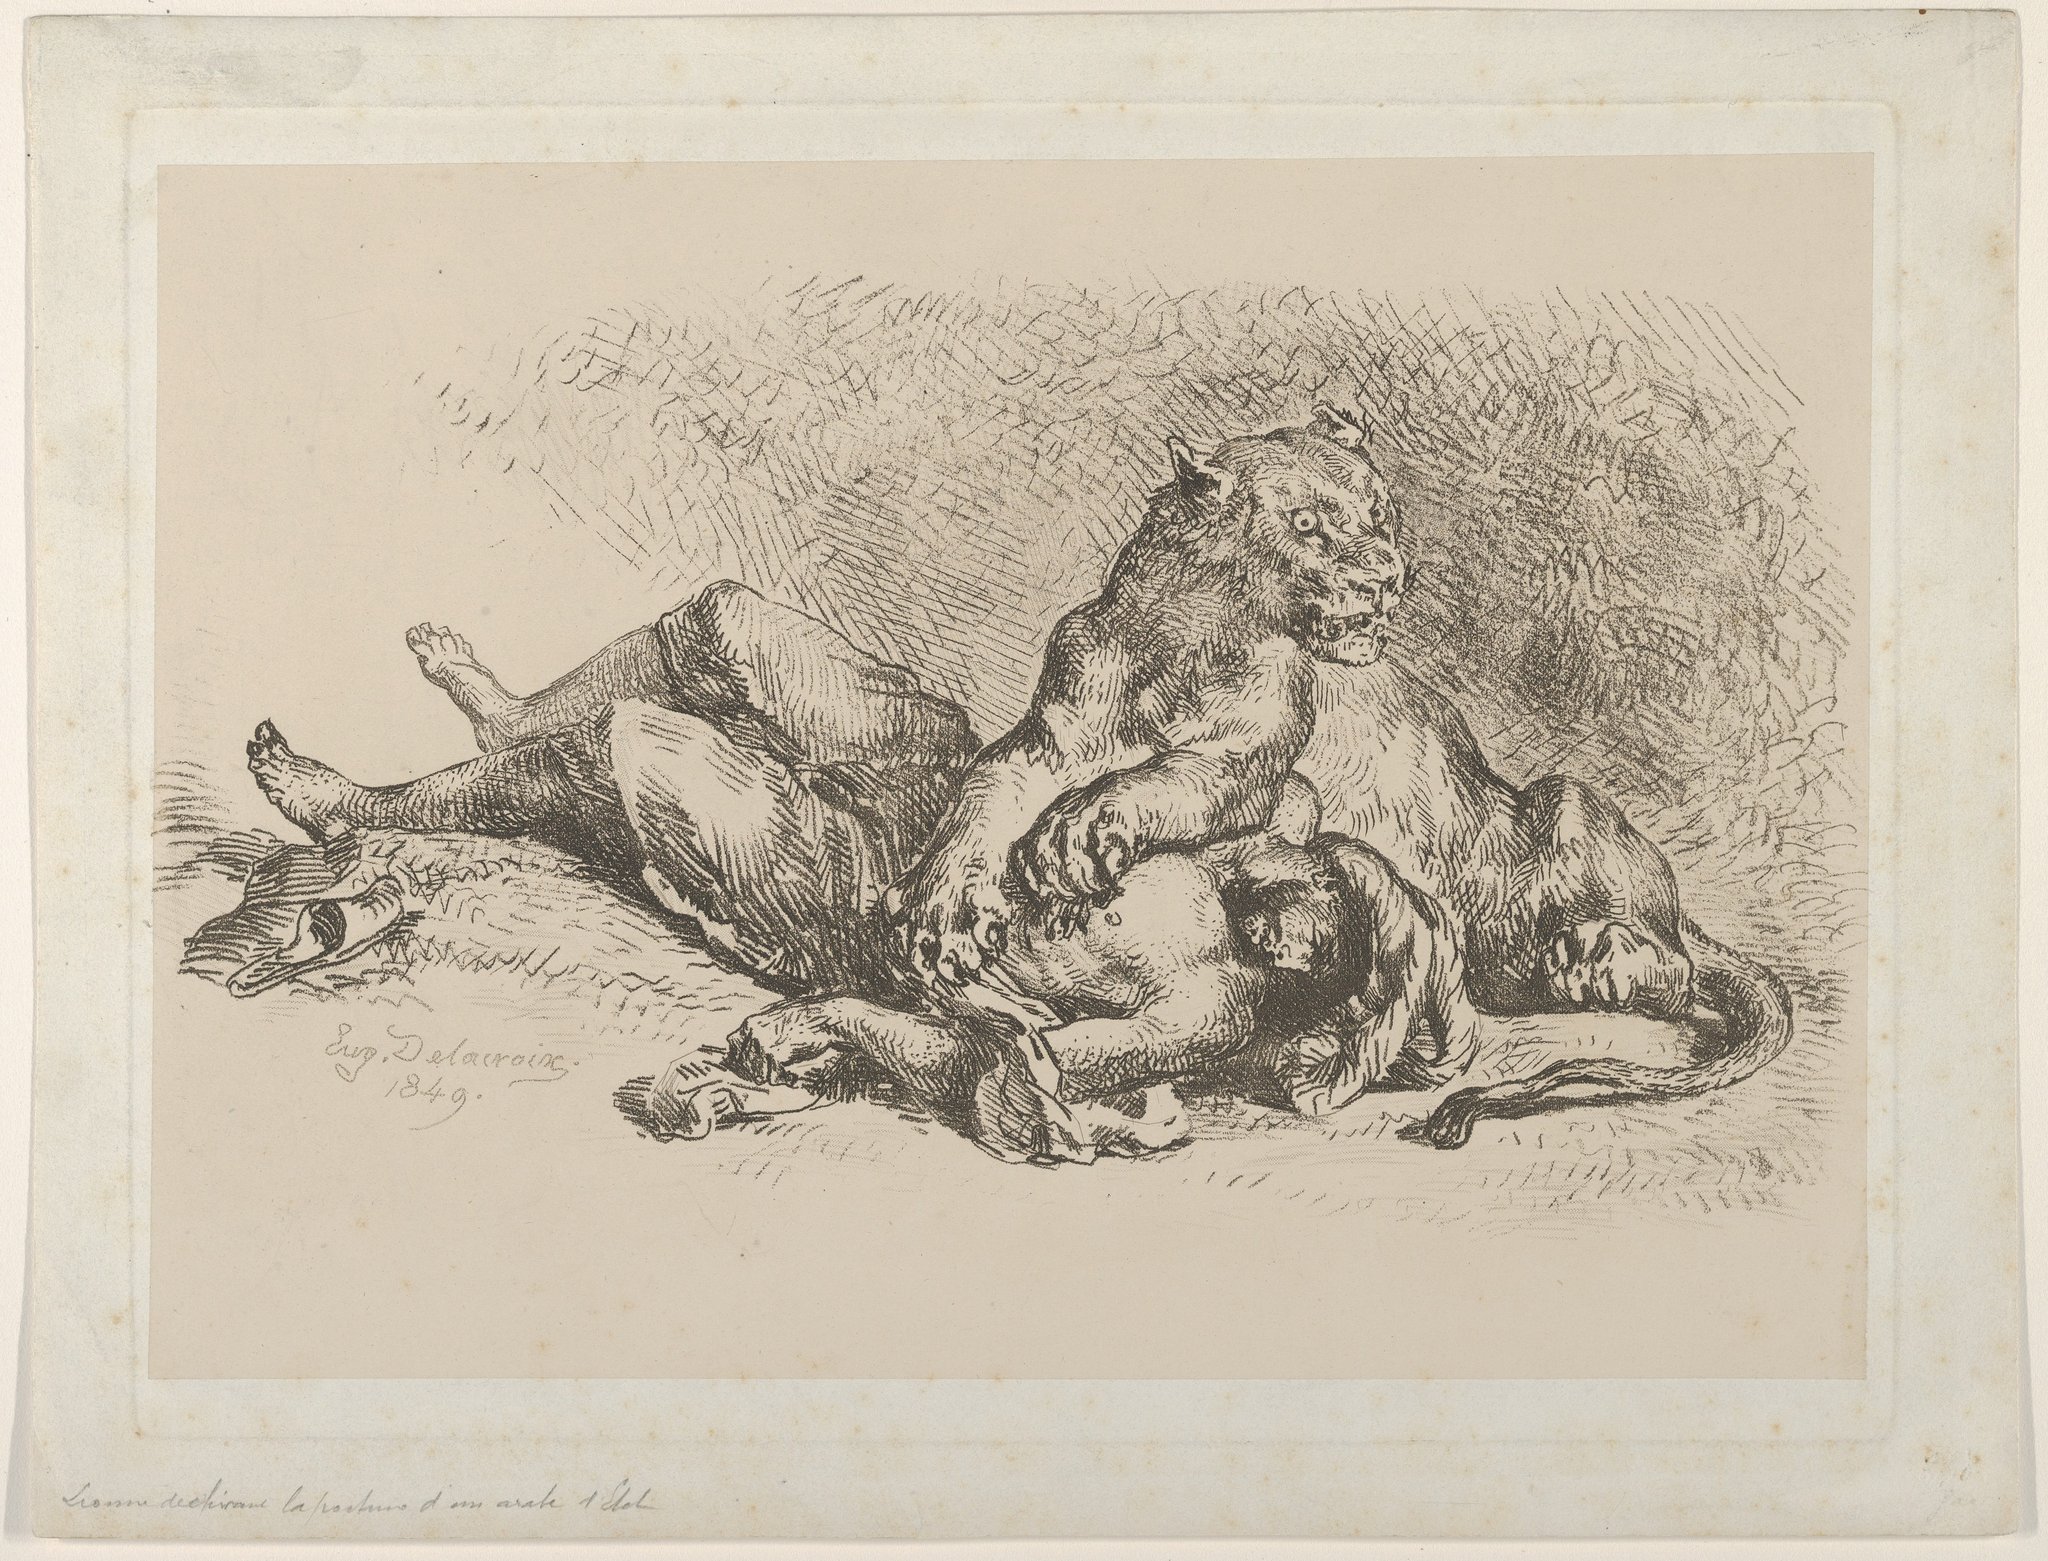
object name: print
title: A Lioness Mauling the Chest of an Arab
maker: eugène delacroix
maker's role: artist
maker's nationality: french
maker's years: 1798-1863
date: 1849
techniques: printmaking, roulette, etching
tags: animals,men